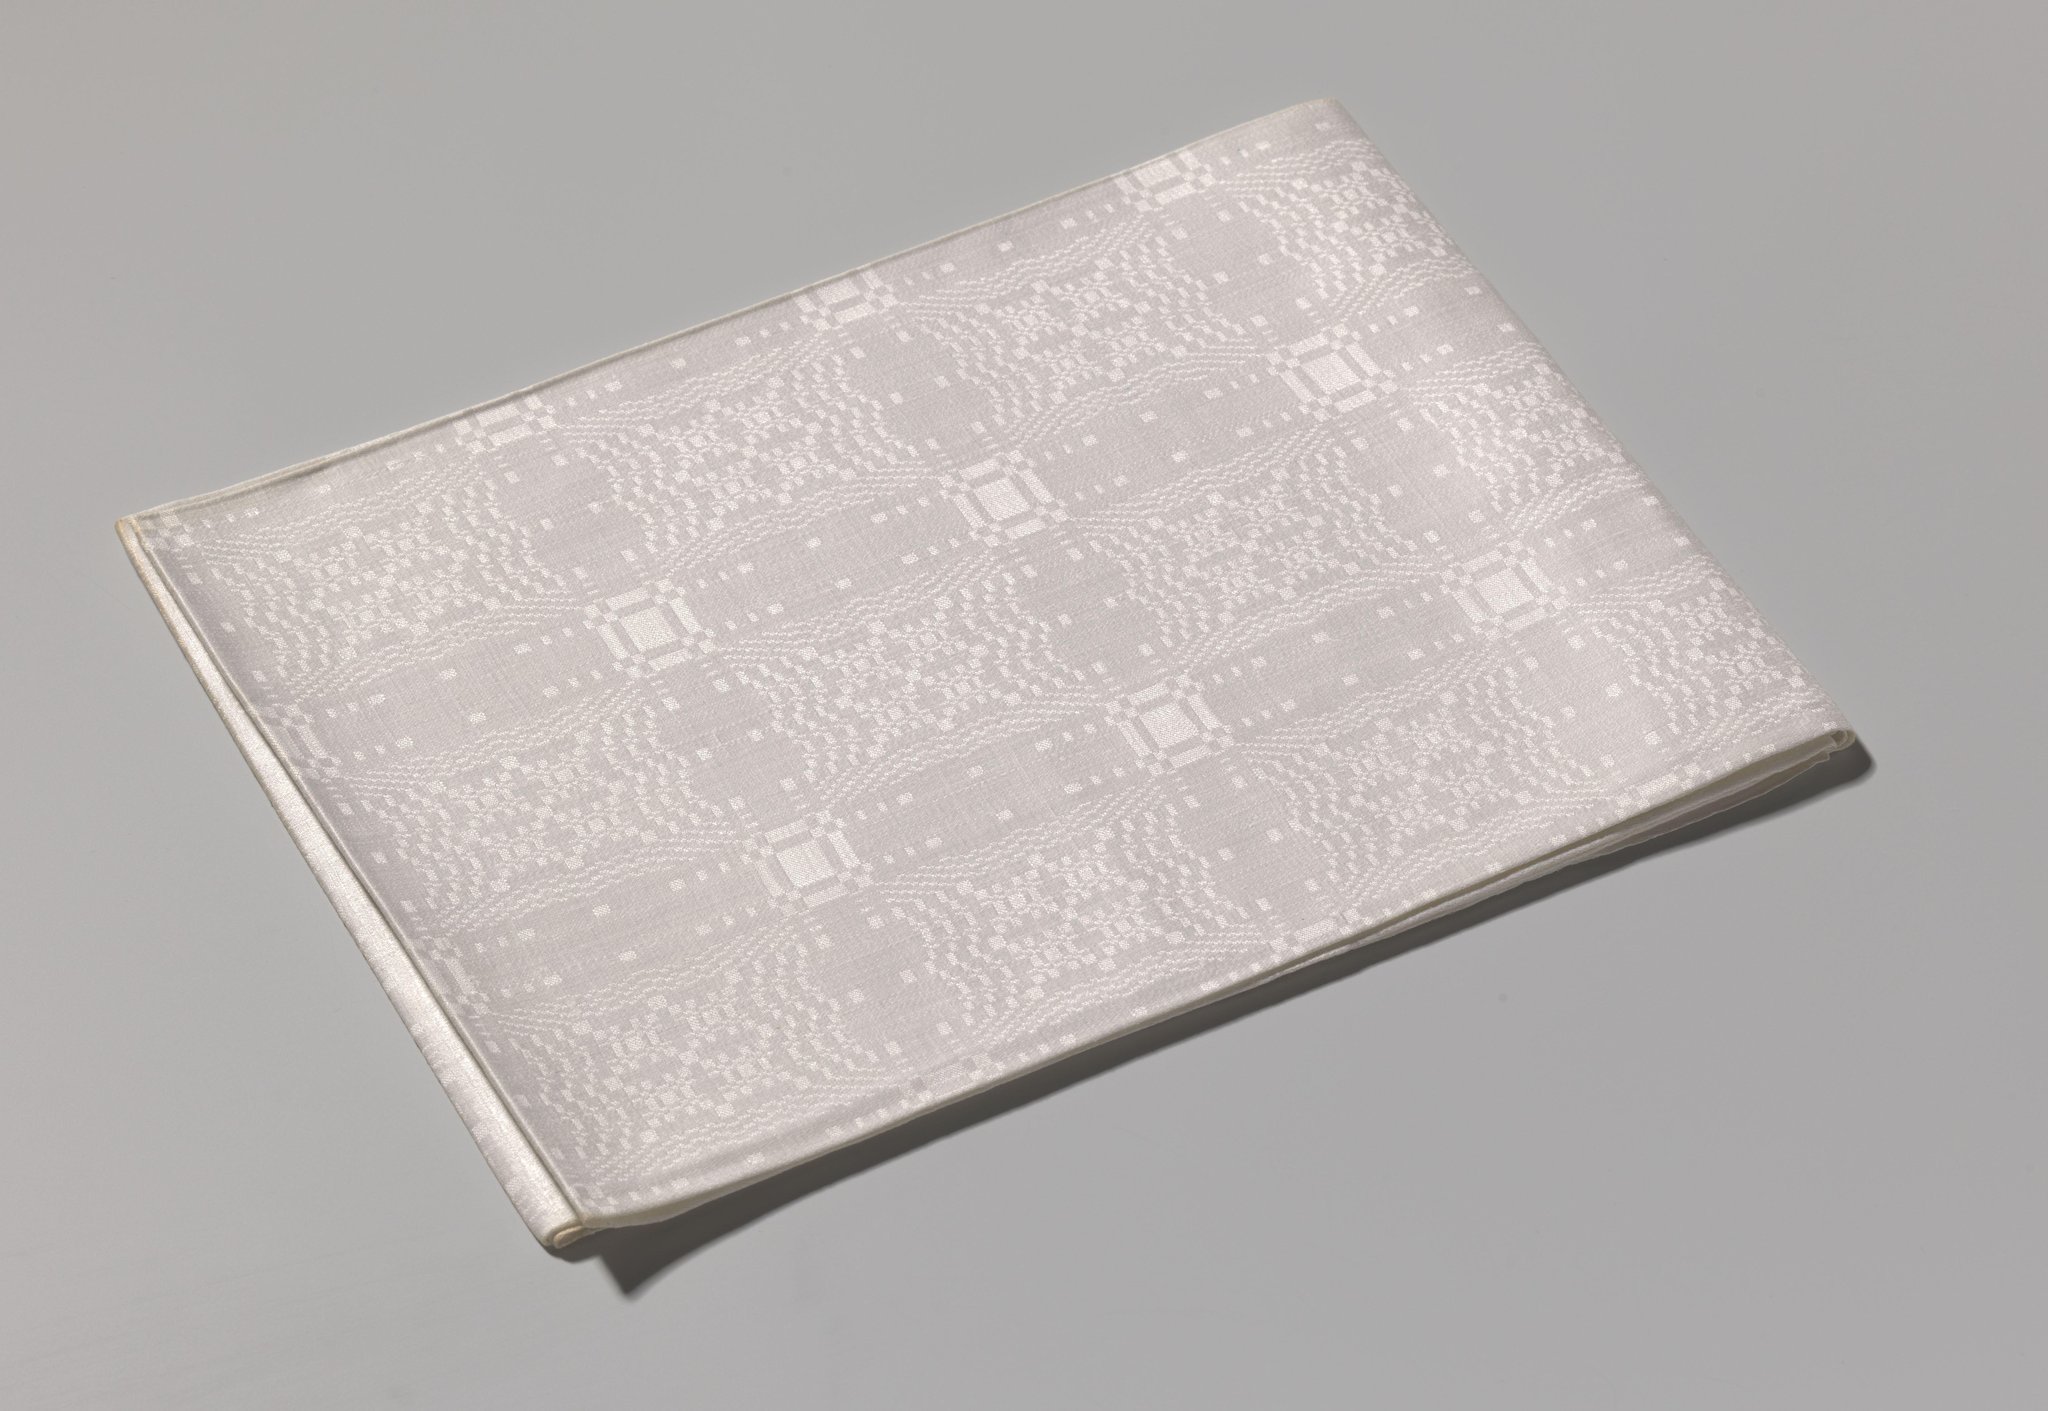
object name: napkin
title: Servet van linnen met pellenpatroon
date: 1400-1950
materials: linen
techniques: peeled fabric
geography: northern netherlands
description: Wit linnendamasten servet met pellenpatroon, merk kroon IS en 96.